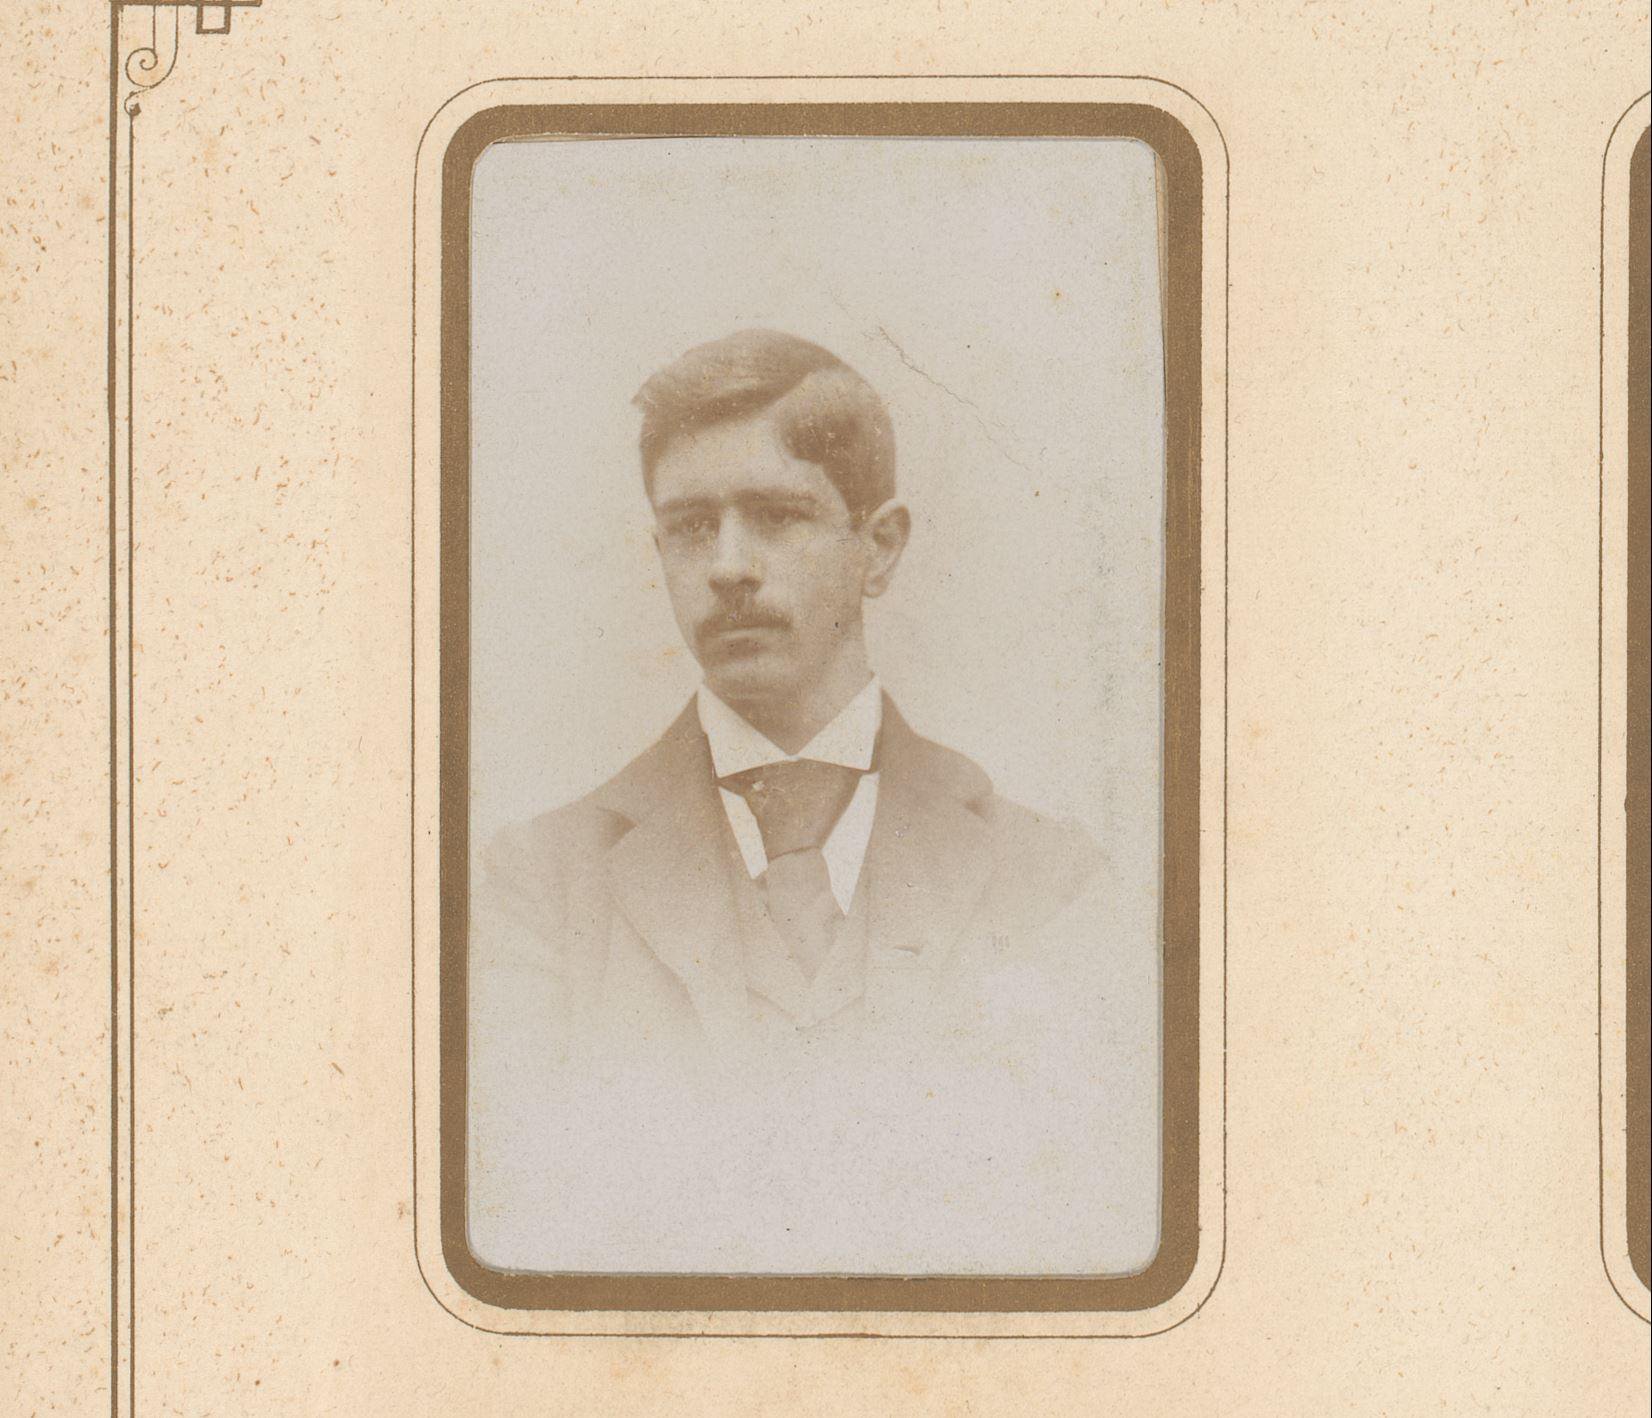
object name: album leaf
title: Portret van een jongeman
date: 1894-1906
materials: cardboard, photographic support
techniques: albumen print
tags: moustache, historical persons, youth, adolescent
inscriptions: inscription: ‘(...)/ Theunisse & Labots/ voorheen Ed. Radermacher/ Rotterdam/ Kruiskade 20/ hoek Kerklaan.’